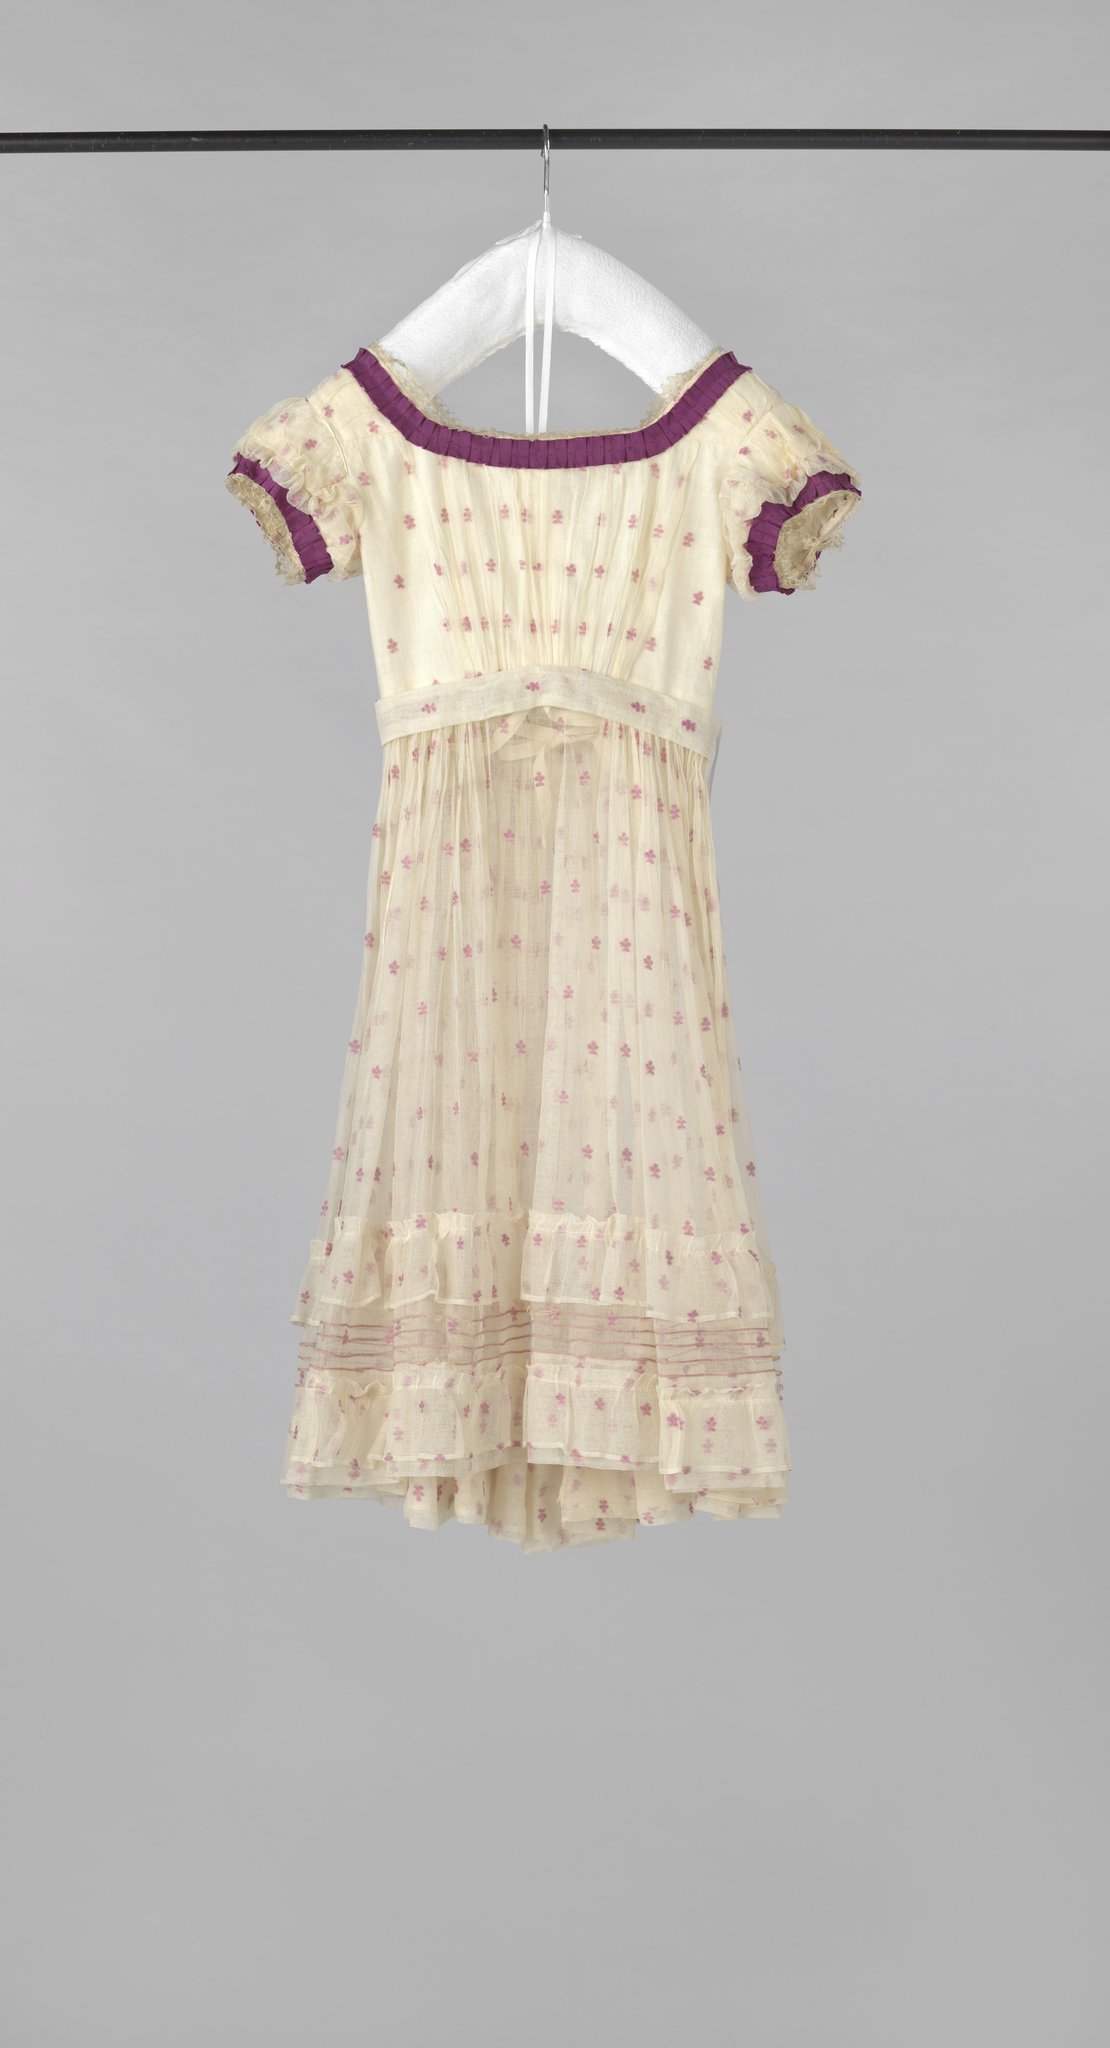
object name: belt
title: Ceintuur met sluiting van haken en ogen, rondom de twee afhangende slippen een ruche, op het aanhechtingspunt van de slippen een rozet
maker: Anonymous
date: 1850-1900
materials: cotton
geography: netherlands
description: Ceintuur met sluiting van haken en ogen. Romdom de twee afhangende slippen een rozet. Op het aanhechtingspunt van de slippen een rozet. Behorend bij een kinderjurk van witte tarlatan met paarse bloemen.